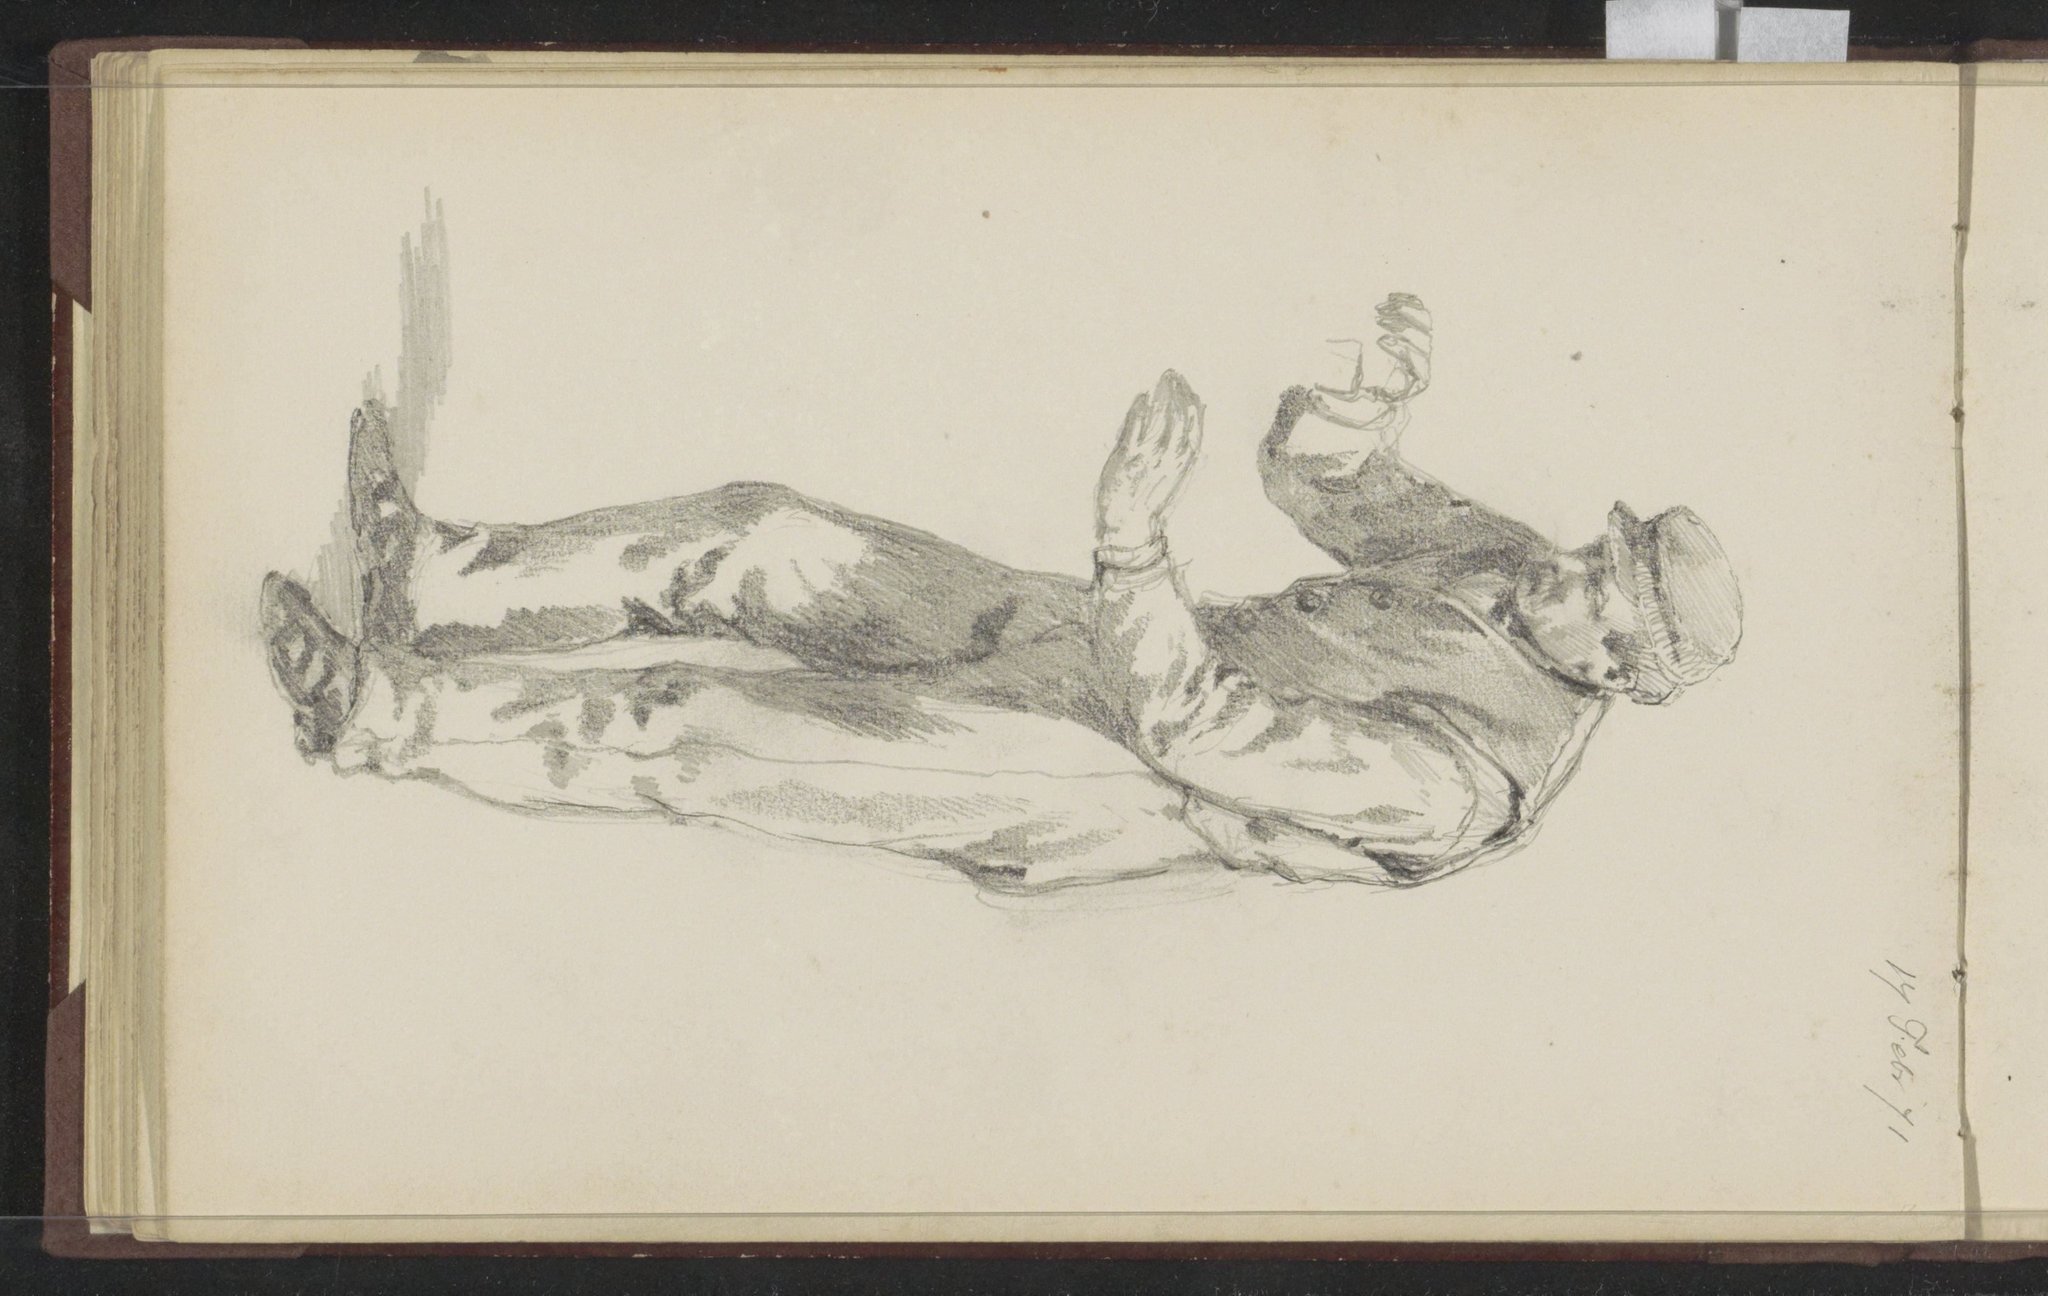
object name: sketchbook leaf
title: Man met een pet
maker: cornelis springer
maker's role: draughtsman, painter, print maker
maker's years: 1817-1891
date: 1871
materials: paper, pencil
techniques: stumping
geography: netherlands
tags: adult man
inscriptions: date: ‘17 Febr 71’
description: Staande man met een pet. Blad 20 verso uit een schetsboek met 39 bladen, deels vervaardigd te Ulm en Leiden.